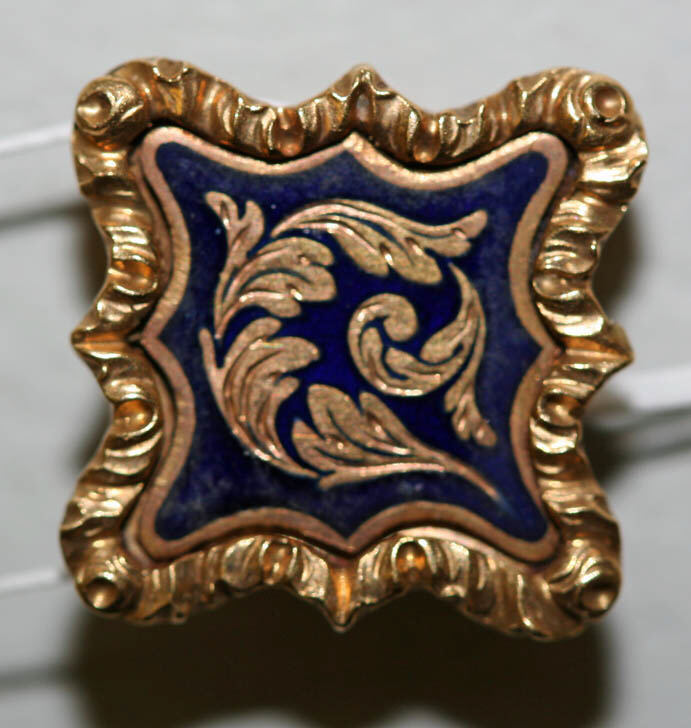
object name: stud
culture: french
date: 1701-1900